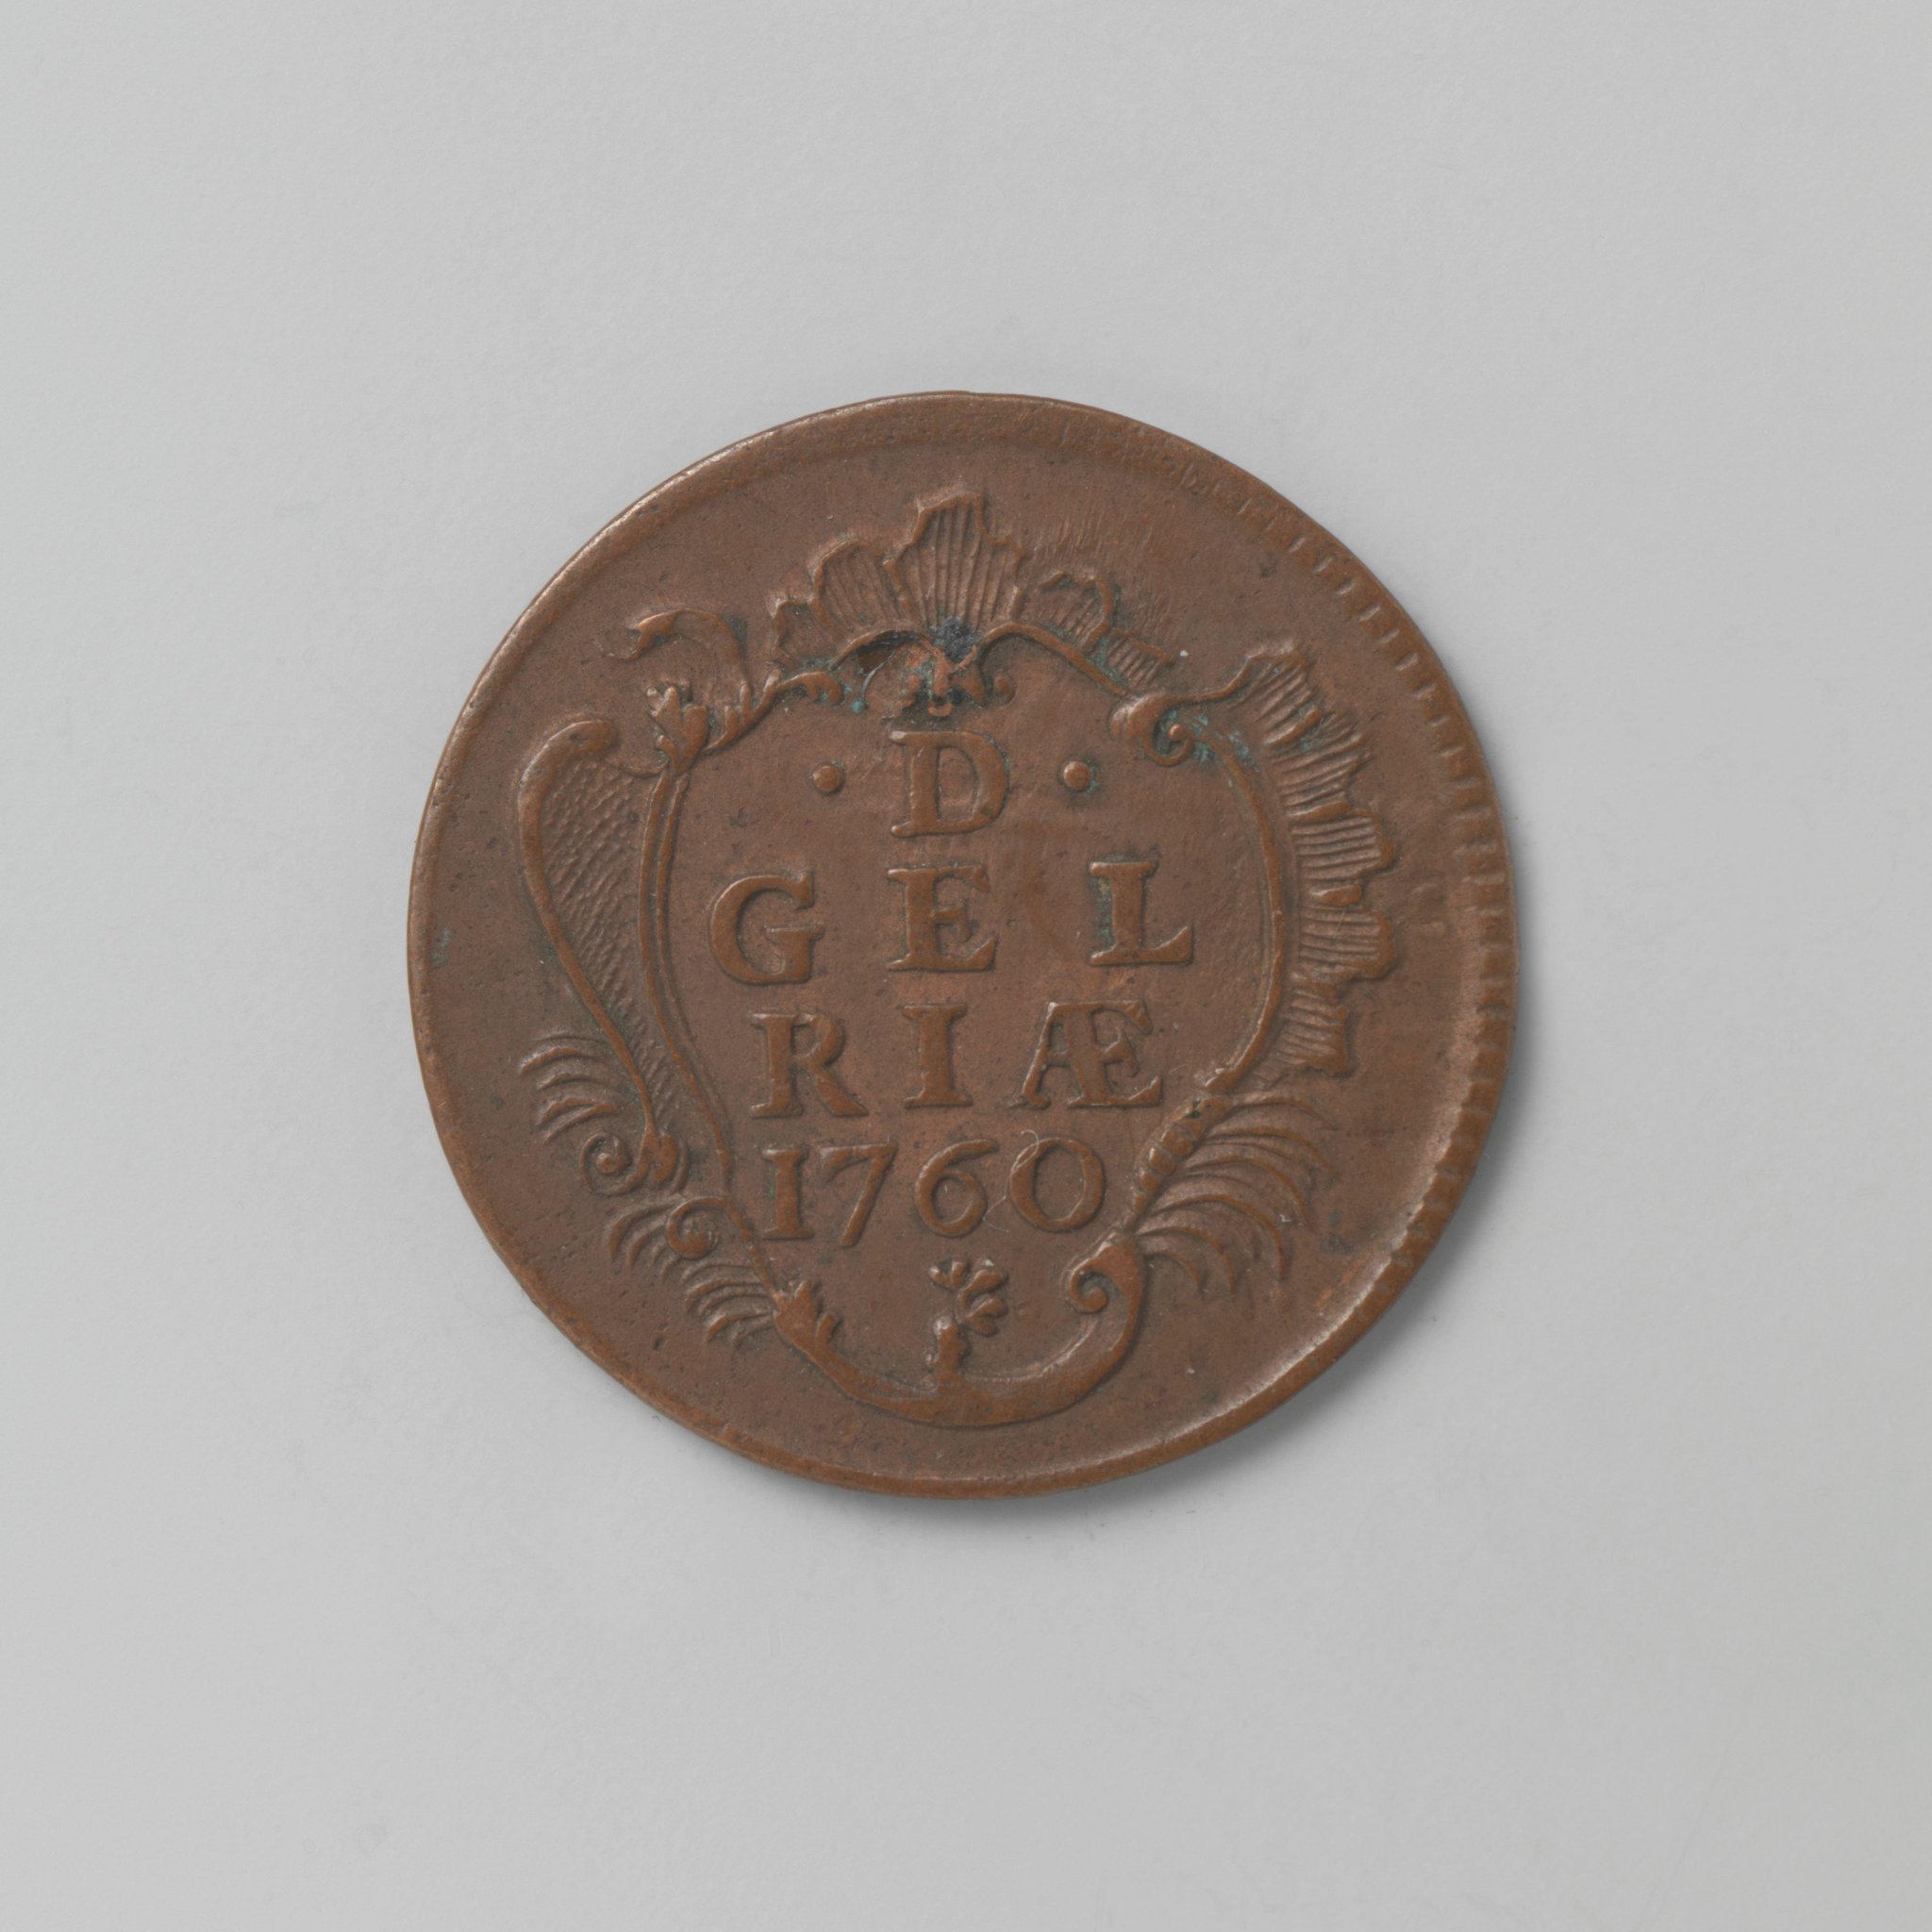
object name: coin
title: Gelderland, duit, 1760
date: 1760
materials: copper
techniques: striking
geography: harderwijk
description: Koperen munt. Voorzijde: binnen weelderige rococo-versiering in drie regels D/GEL/RIAE, daaronder jaartal en muntmeesterteken. Keerzijde: gekroond Gelders wapenschild.